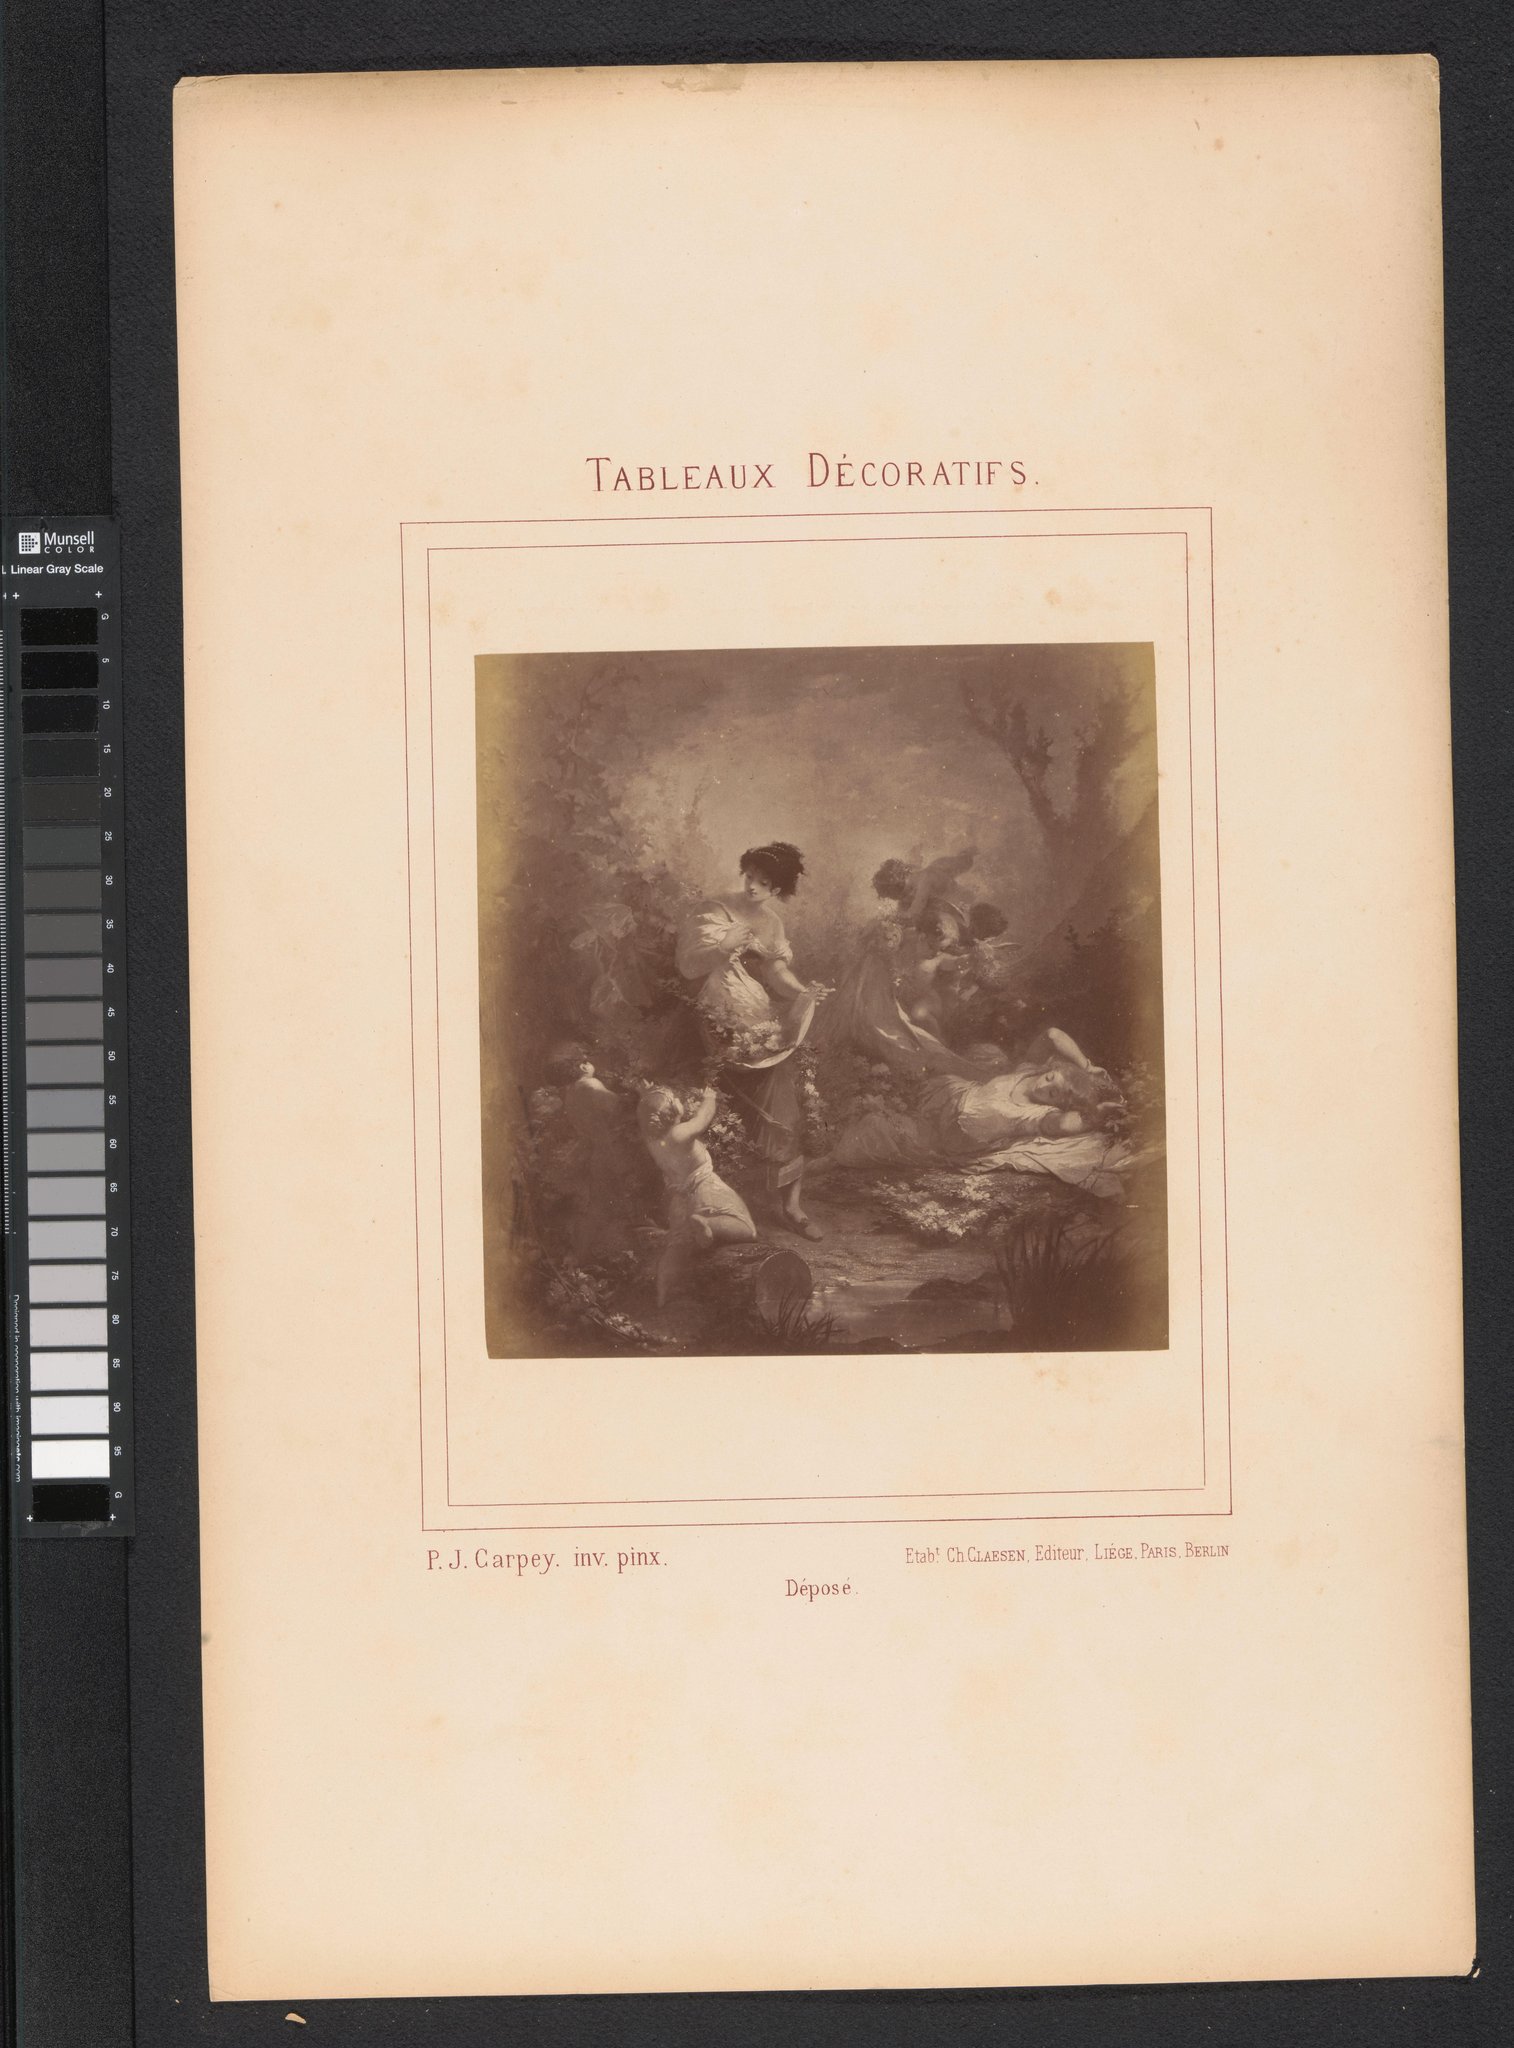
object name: photograph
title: Déposé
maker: paul-joseph carpay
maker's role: painter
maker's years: 1822-1892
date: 1874-1881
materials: photographic support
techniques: albumen print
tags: adult woman, child, playing in the woods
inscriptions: inscription: ‘Etabt. Ch.Claesen , Editeur , Liége , Paris , Berlin’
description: Deze foto maakt deel uit van een omslag met 24 foto's op 22 bladen.